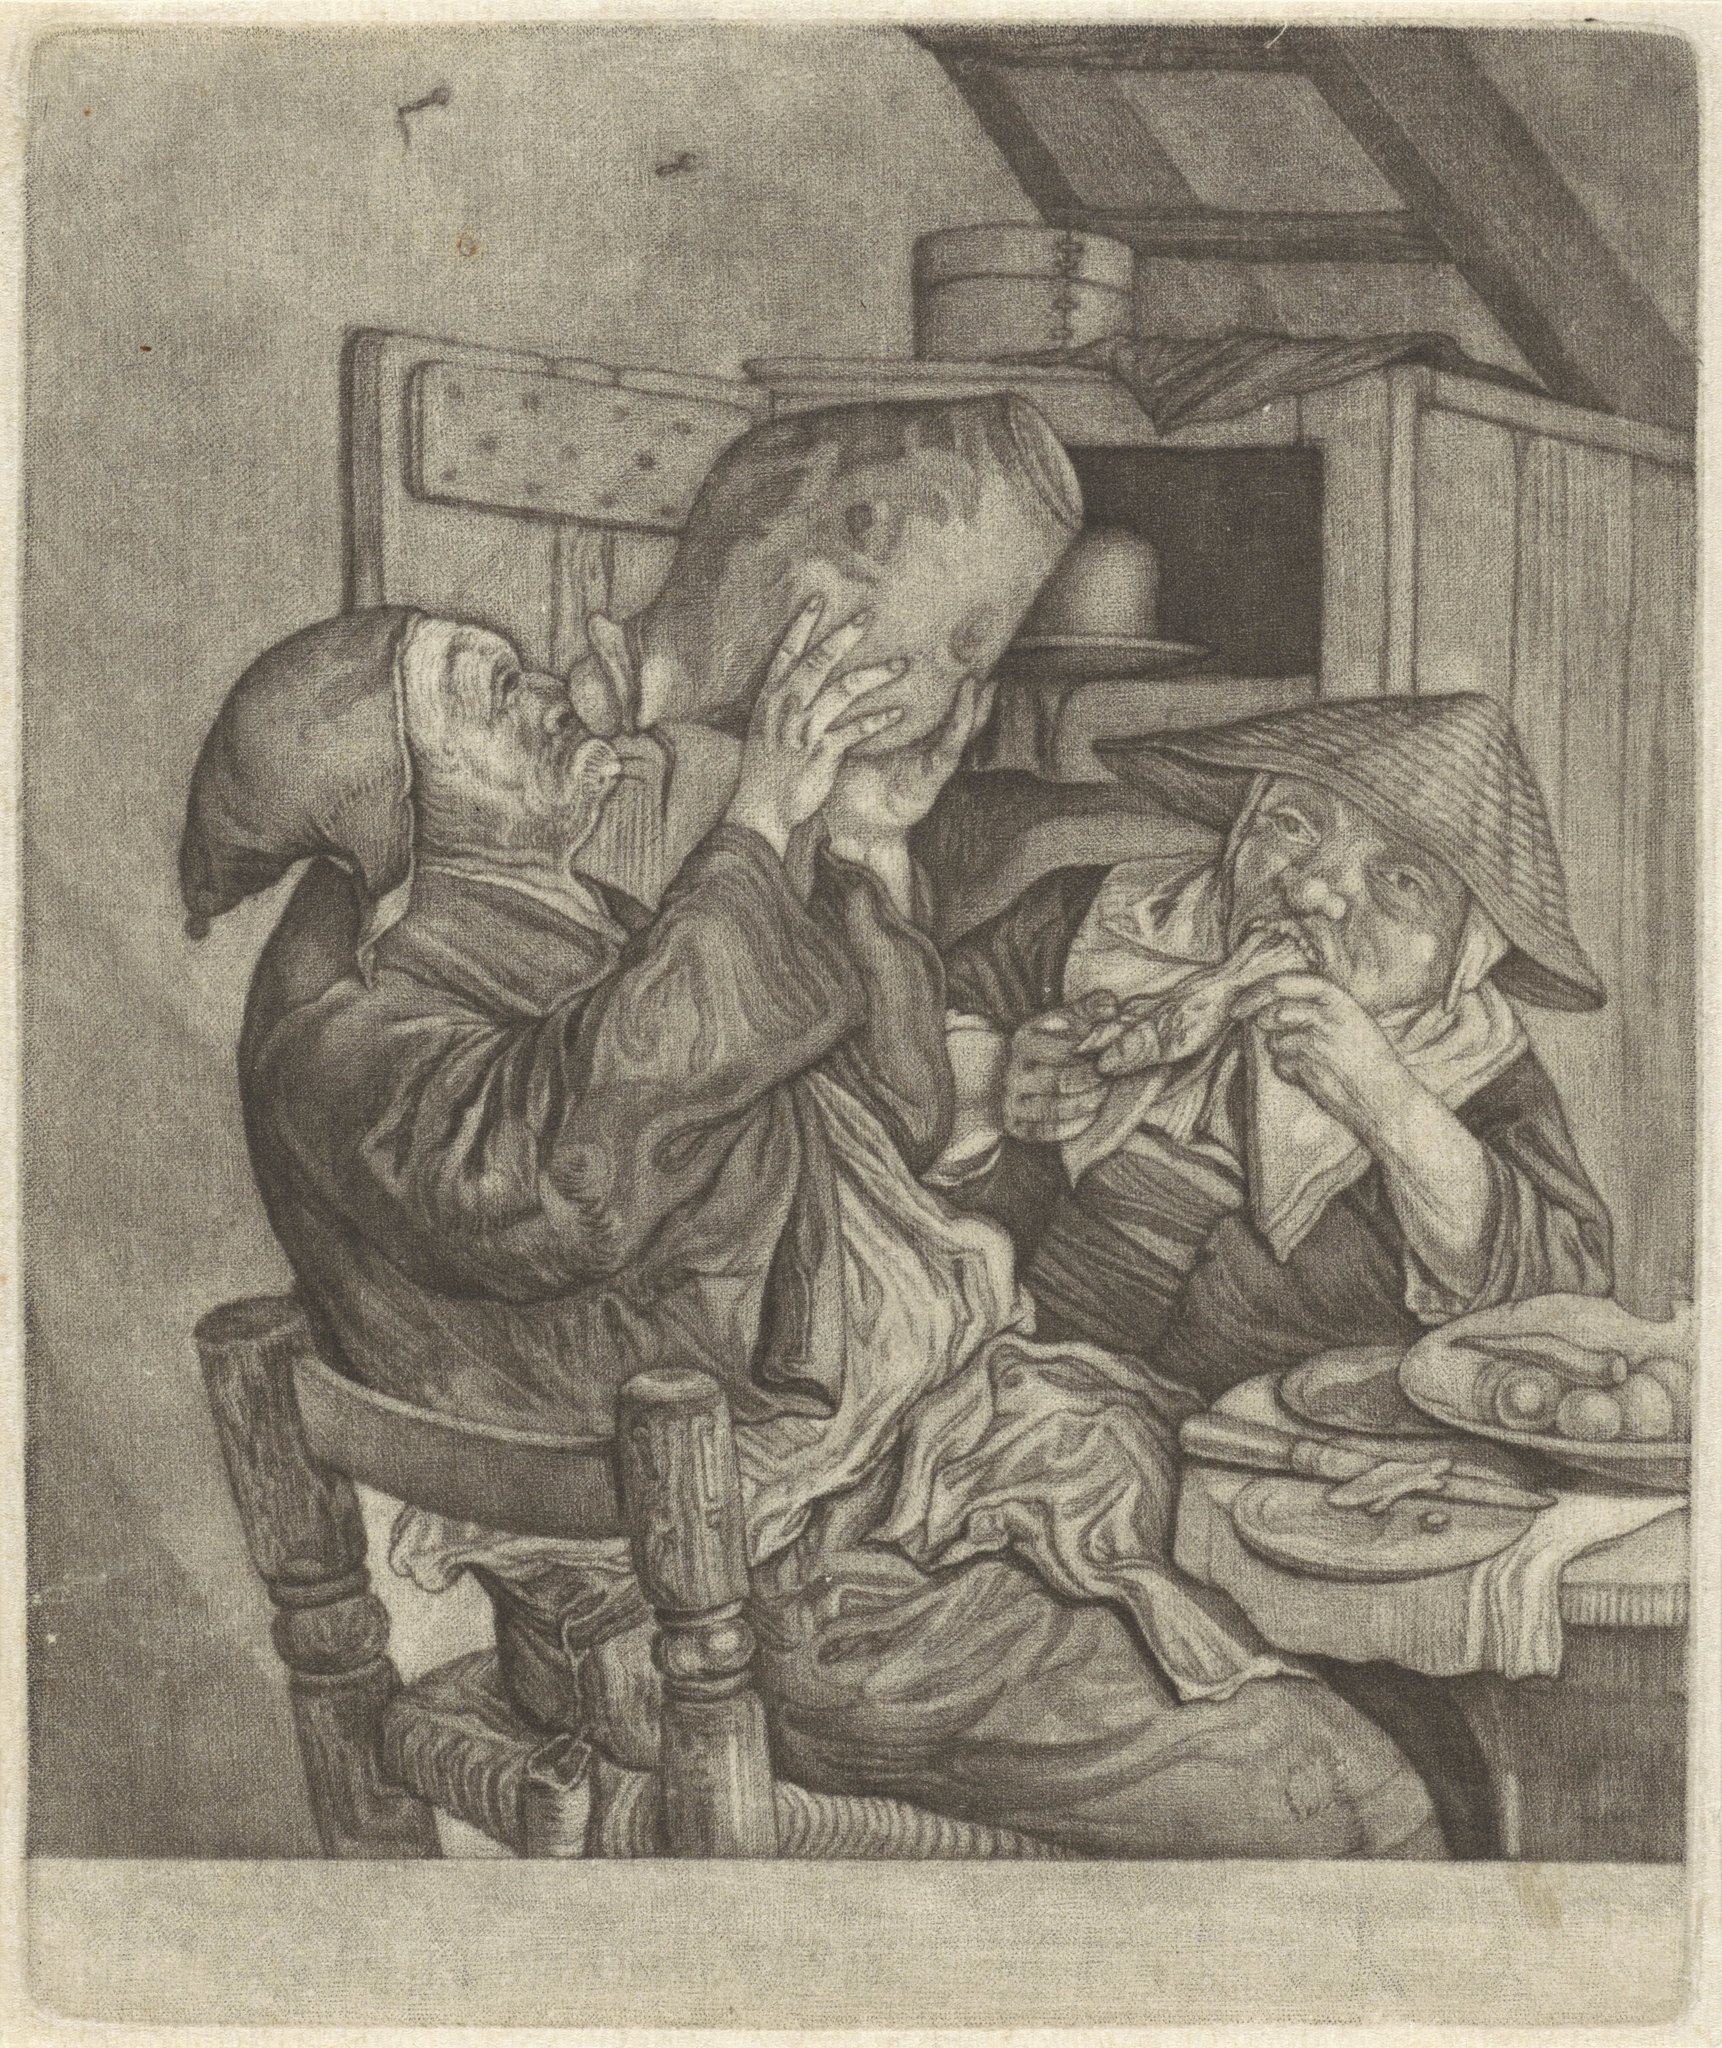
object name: print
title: Smaak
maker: cornelis dusart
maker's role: draughtsman, painter, print maker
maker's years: 1660-1704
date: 1679-1704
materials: paper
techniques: mezzotint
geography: haarlem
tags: taste, tasting (one of the five senses), farmers, drinking, eating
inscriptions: collector's mark: Lugt 2228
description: Het zintuig Smaak. Een boerenpaar aan de maaltijd. De prent maakt deel uit van een serie van vijf prenten met de vijf zintuigen.